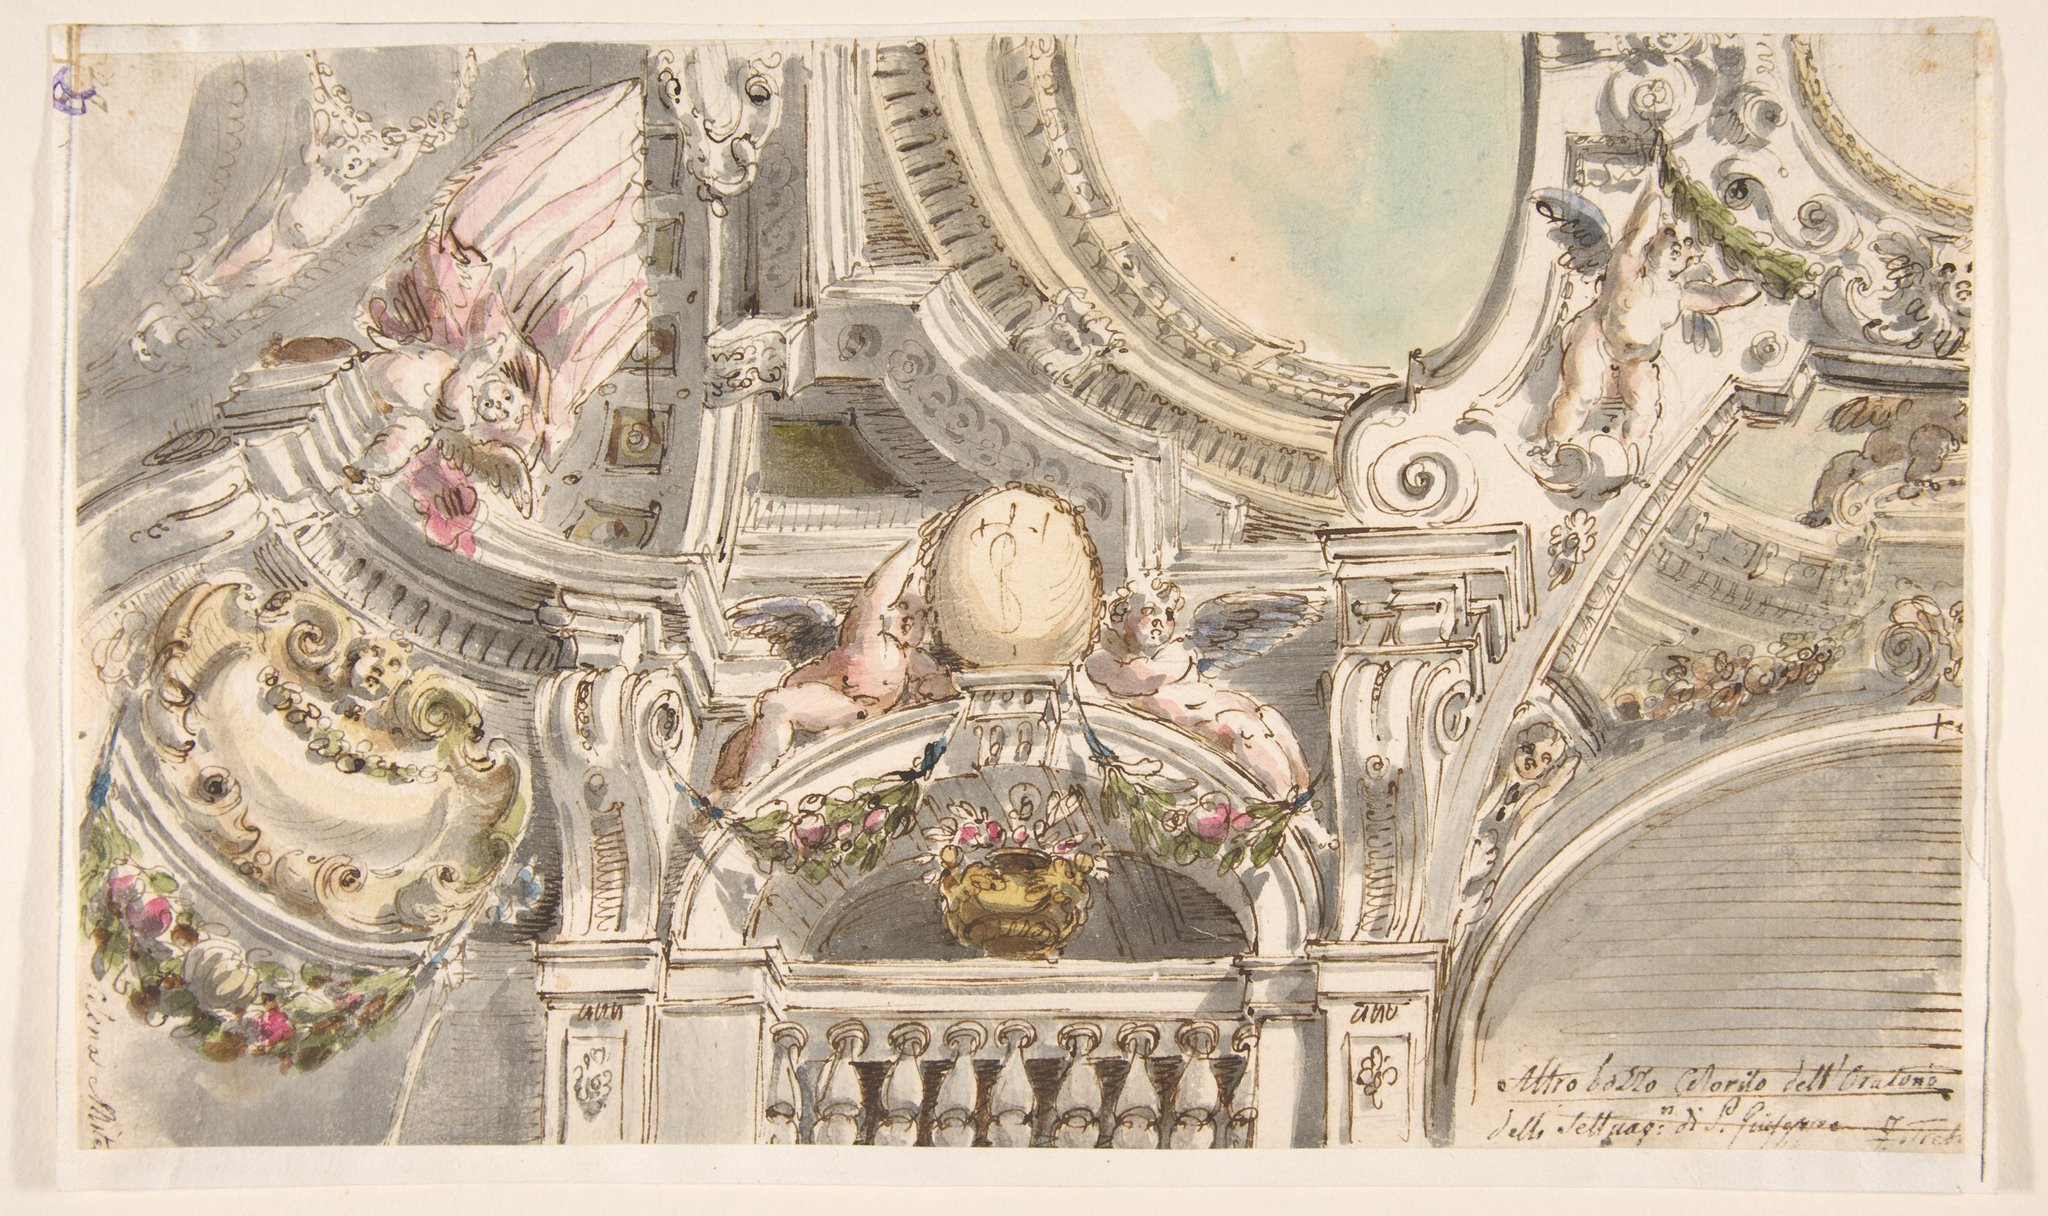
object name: drawing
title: Design for a Ceiling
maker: faustino trebbi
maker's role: artist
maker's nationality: italian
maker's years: 1761-1836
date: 1761-1836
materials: ink, watercolor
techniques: brush, pen, wash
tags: ceilings